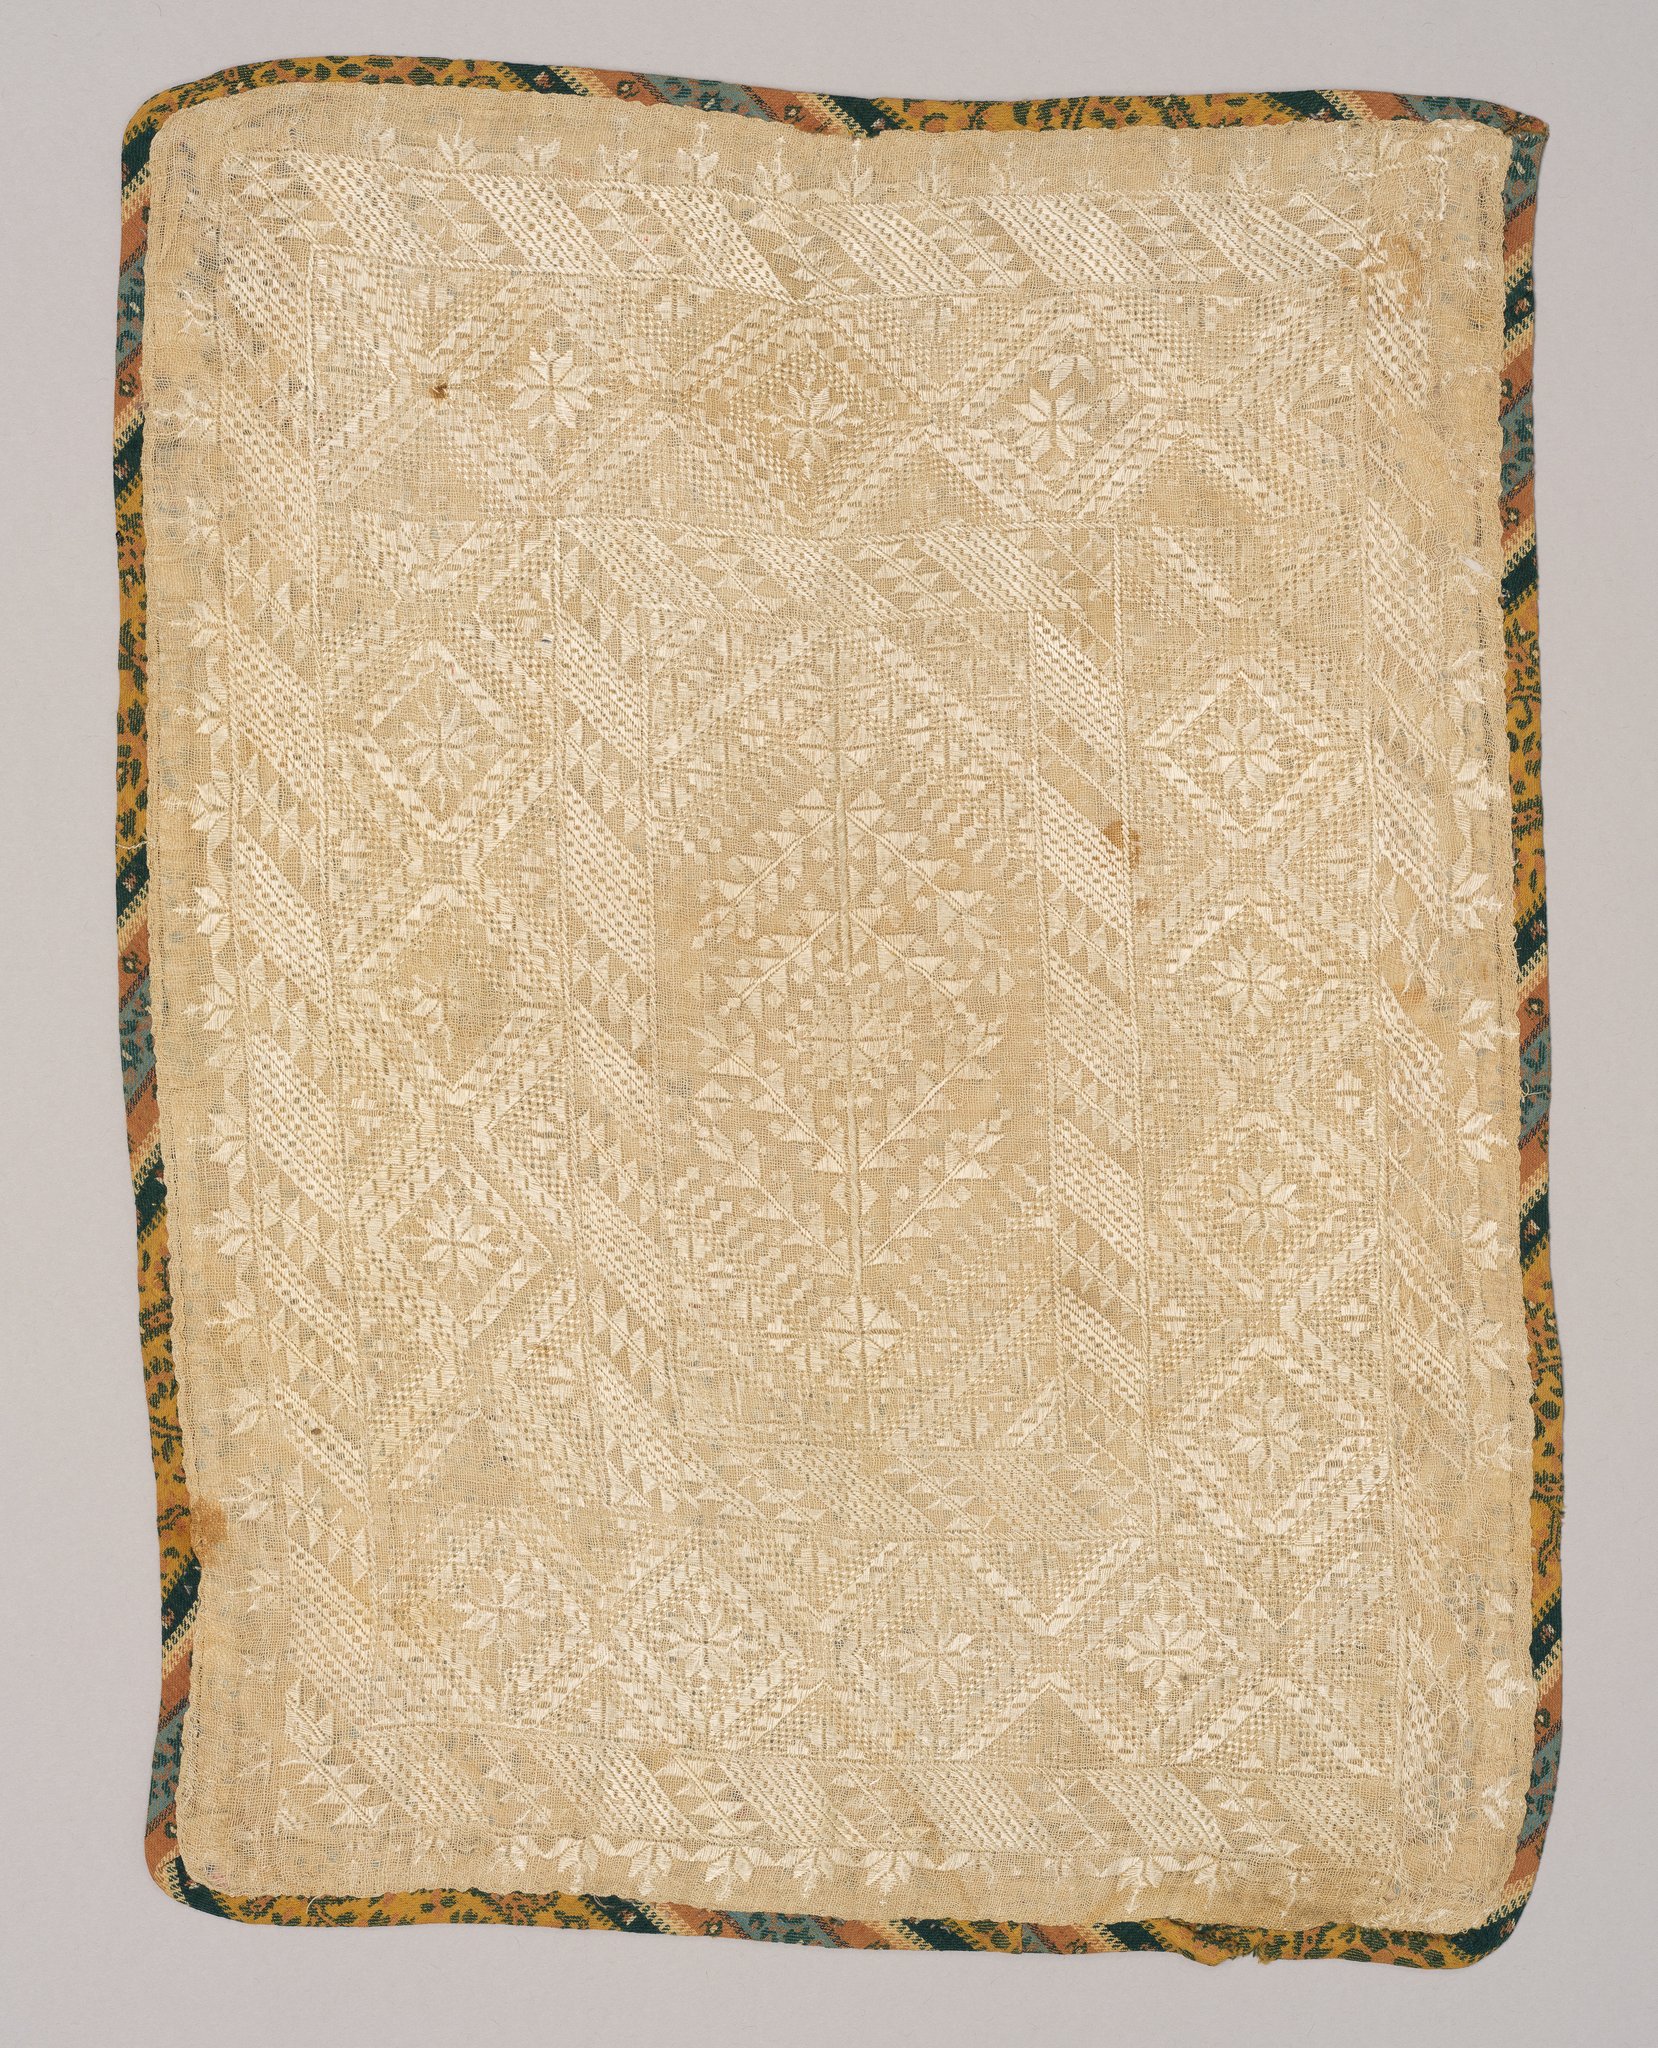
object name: cover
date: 1701-1800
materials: cotton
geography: iran